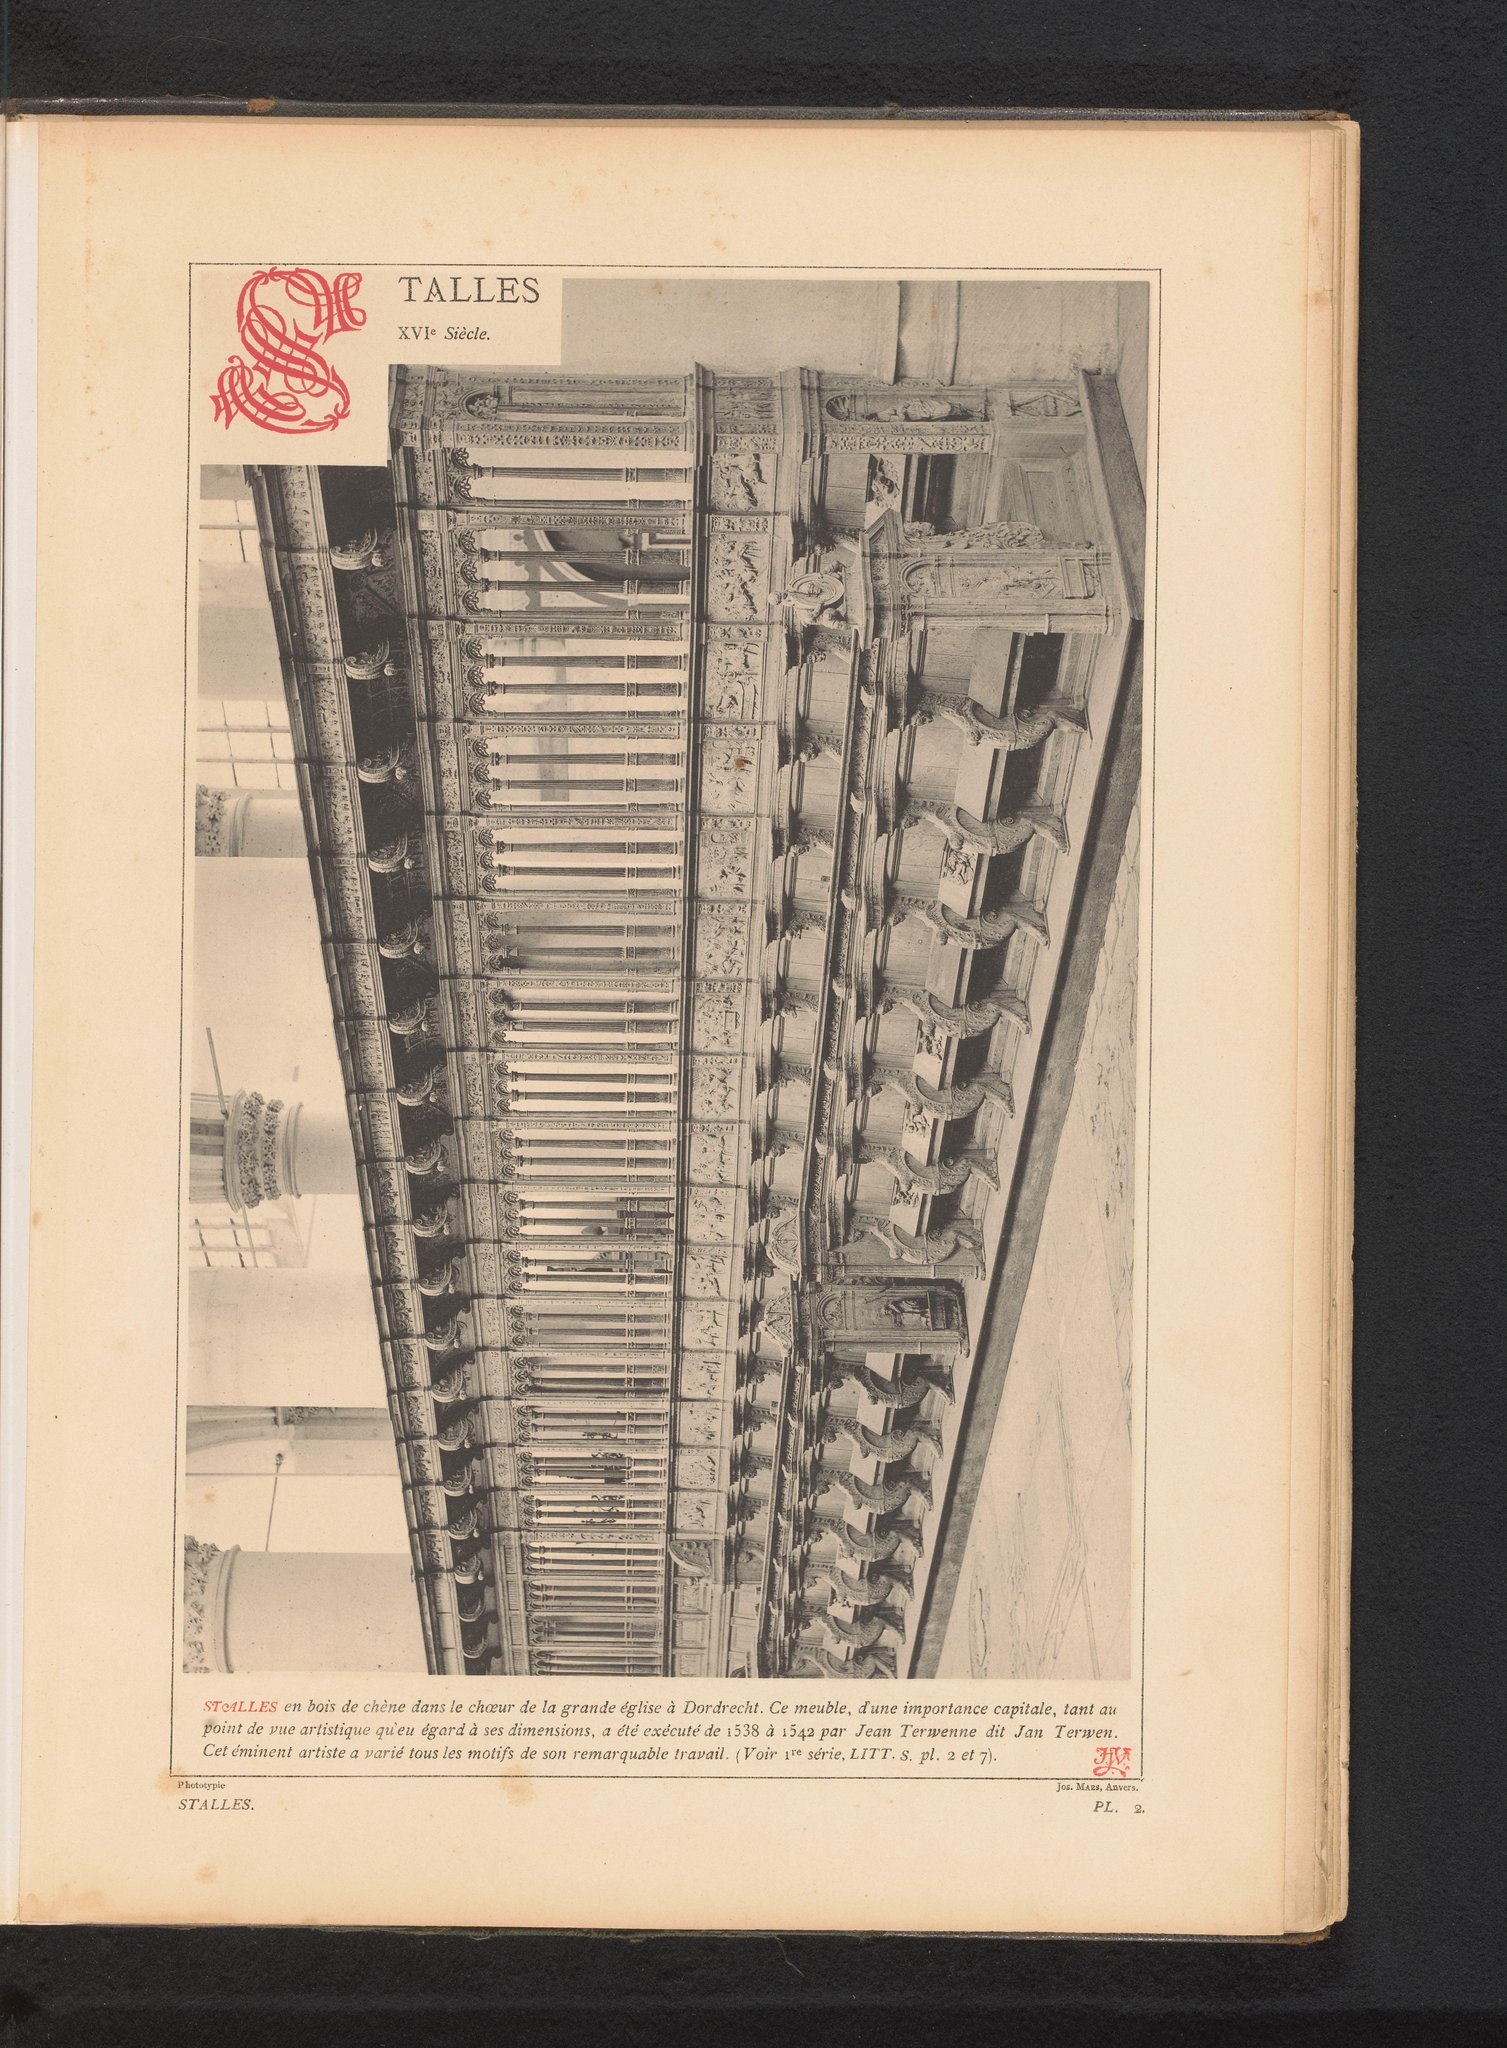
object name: page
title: Stalles, XVIe Siècle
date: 1881-1889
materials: paper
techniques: photograph, photolithography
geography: dordrecht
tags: seats of the clergy, choir-stalls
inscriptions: inscription: ‘STALLES en bois (...)’, inscription: ‘STALLES. PL. 2.’, monogram: ‘JJvY’